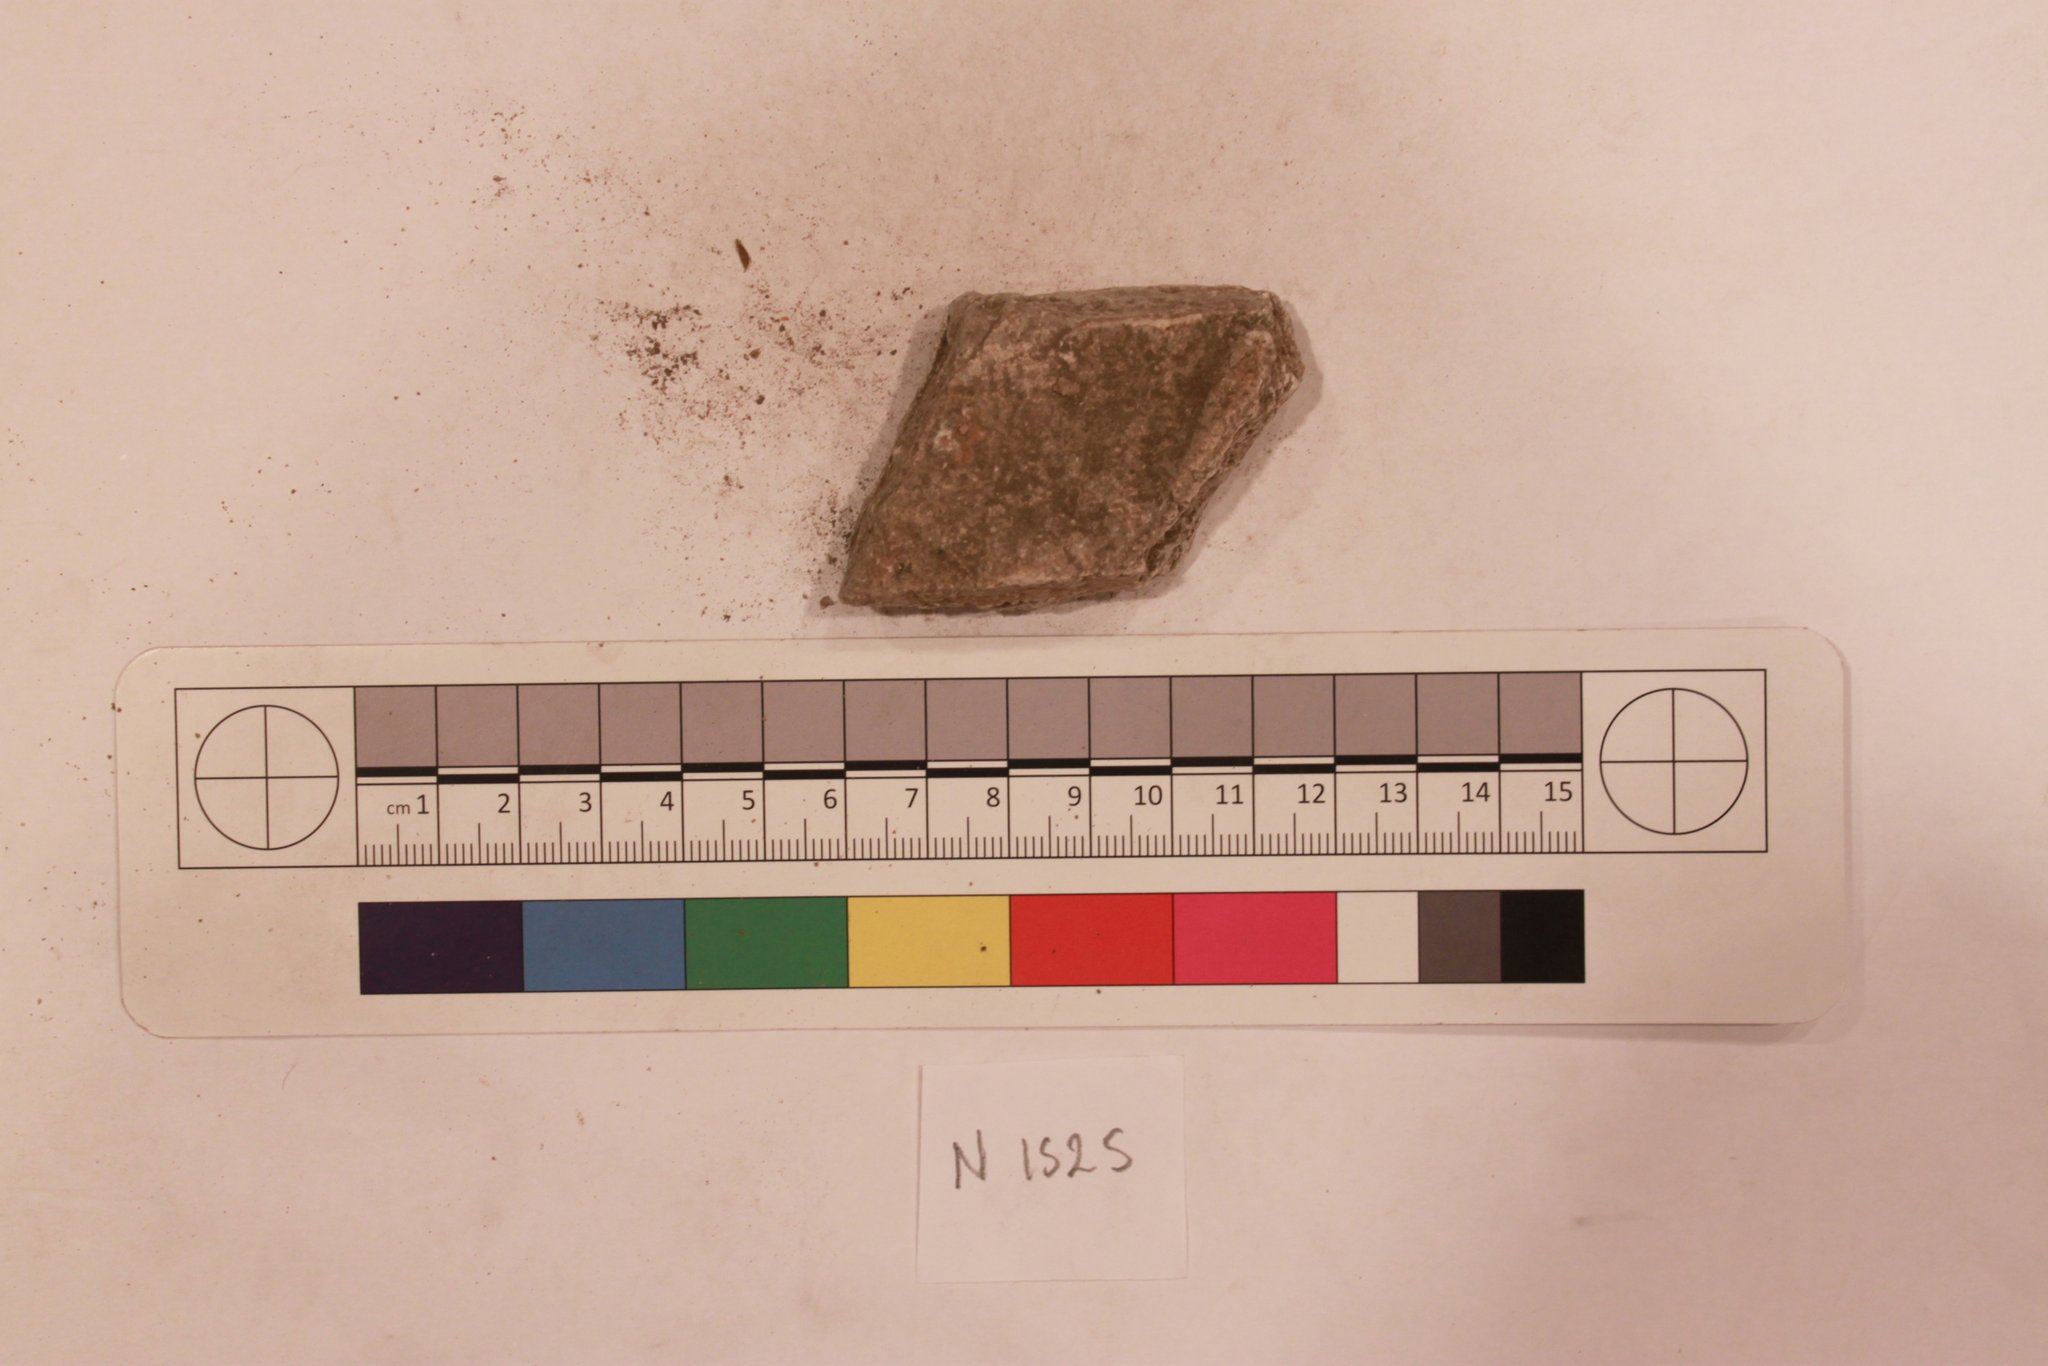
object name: fragment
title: Stucco Fragment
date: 701-1200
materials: plaster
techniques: carving, painting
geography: iran